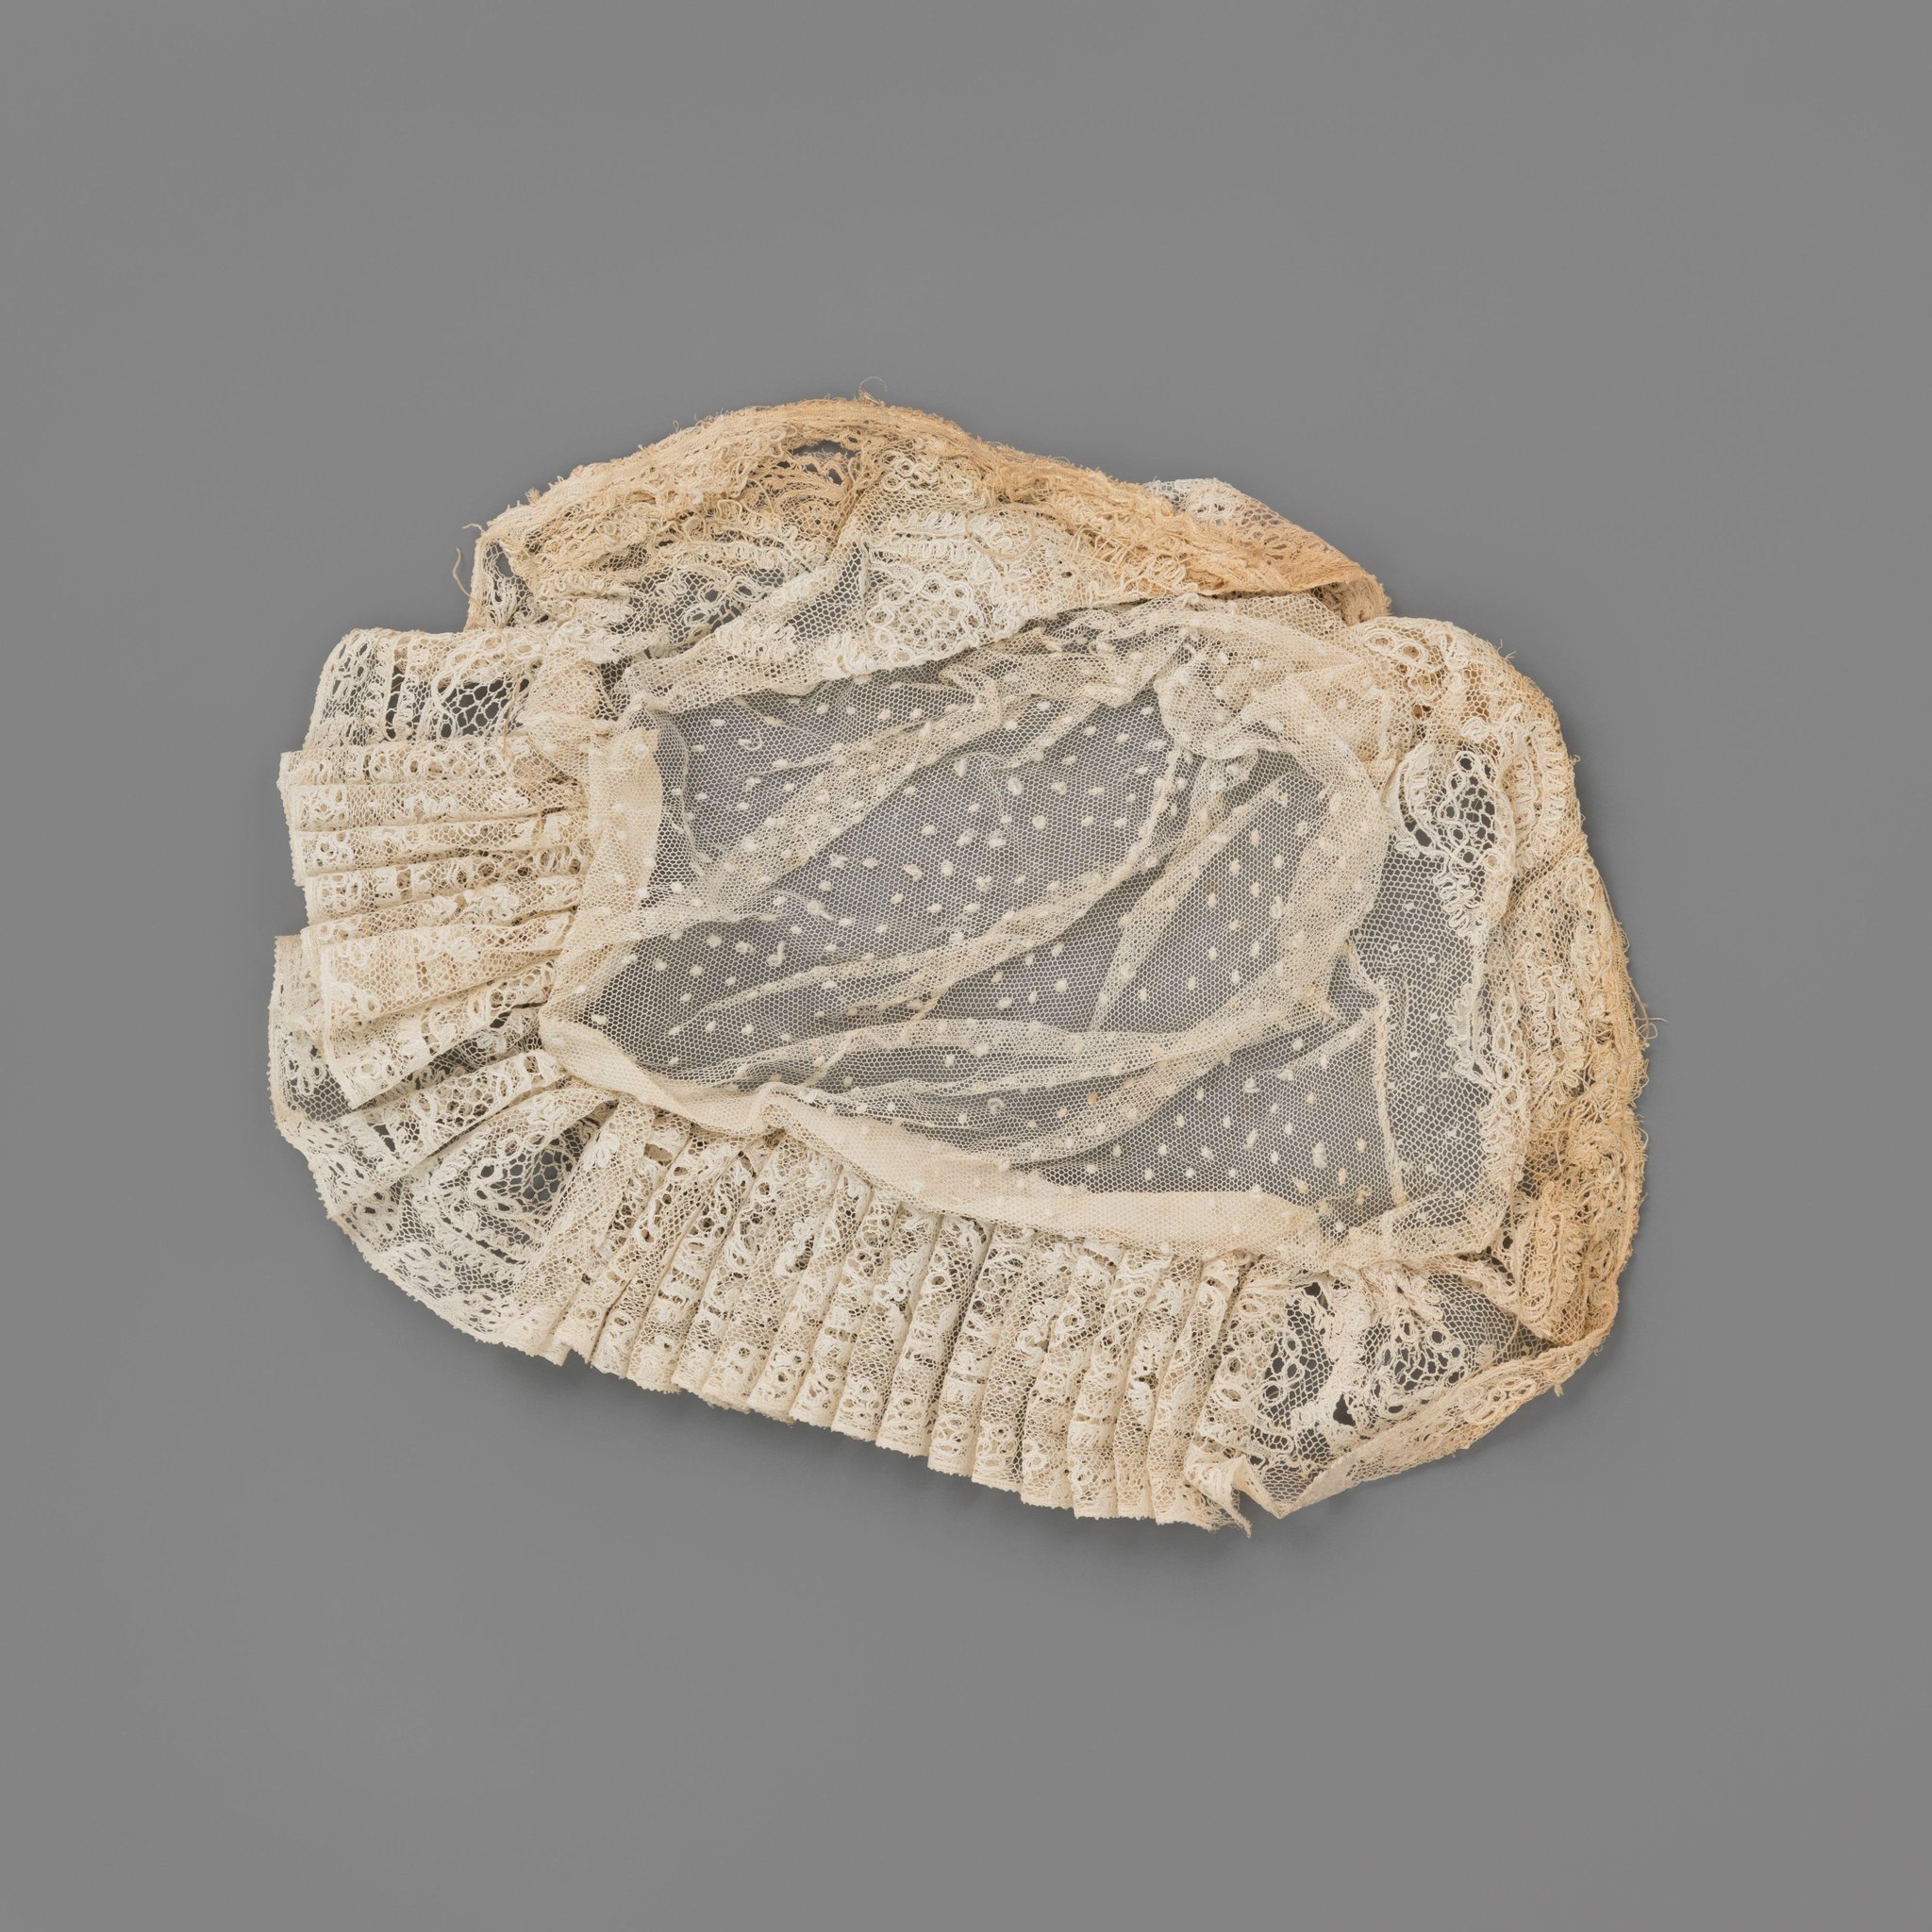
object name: womenswear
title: Muts van tule met Rijsselse kant; de bol van met moesjes geborduurde tule is langs het voorhoofd afgezet met een geplooide strook Rijsselse kant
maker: Anonymous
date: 1800-1900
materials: linen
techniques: material, embroidered, lace, weave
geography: lille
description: Muts van tule met Rijsselse kant. De bol van met moesjes geborduurde tule is afgezet met een strook Rijsselse kant. Langs het voorhoofd is het kant geplooid.